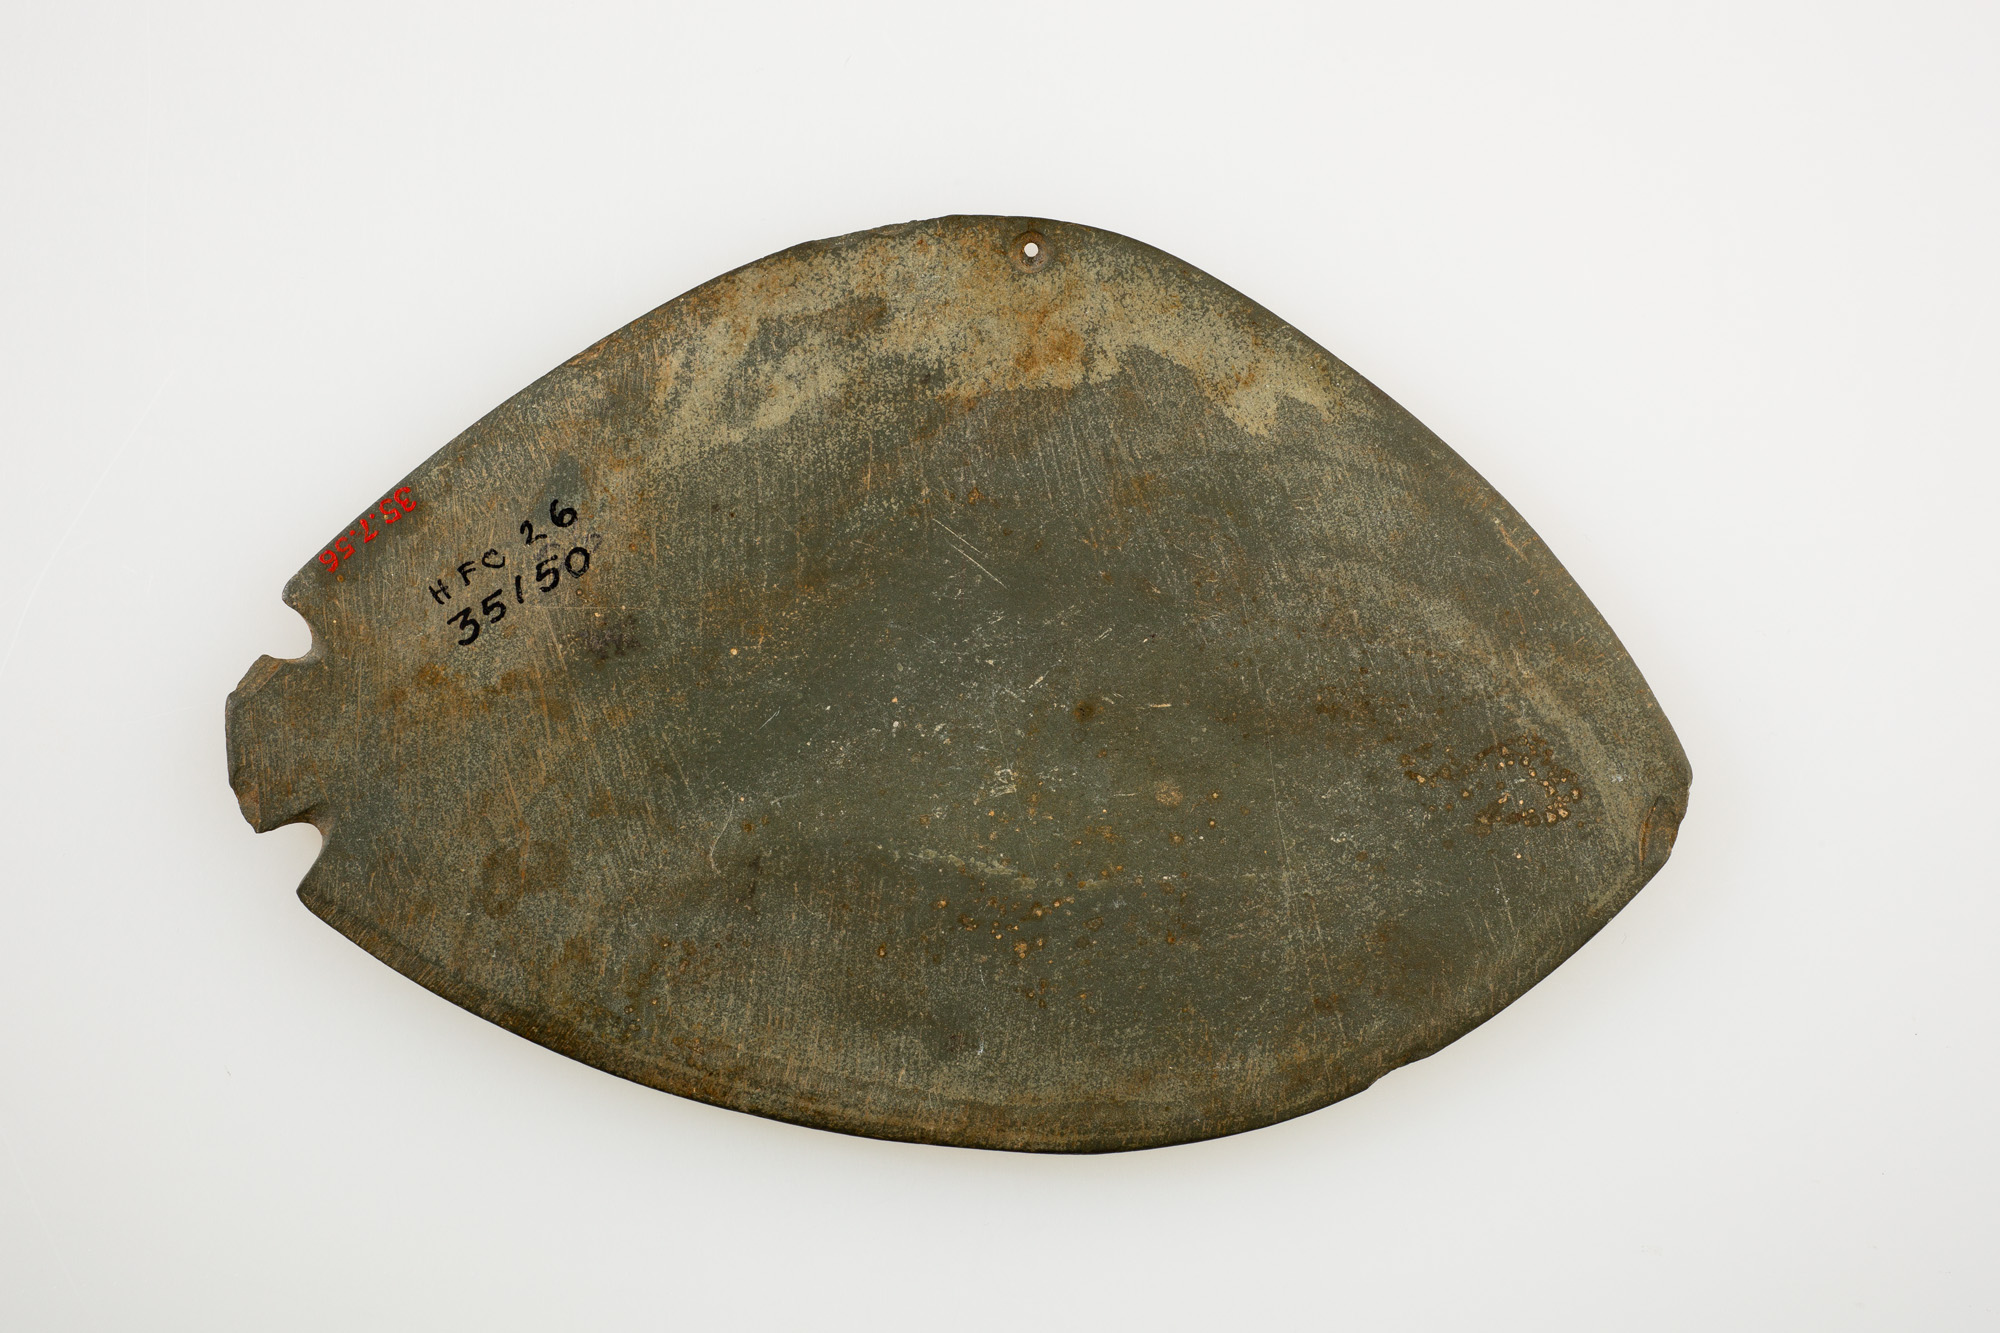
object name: palette, fish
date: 3300-2960 BCE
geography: egypt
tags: fish